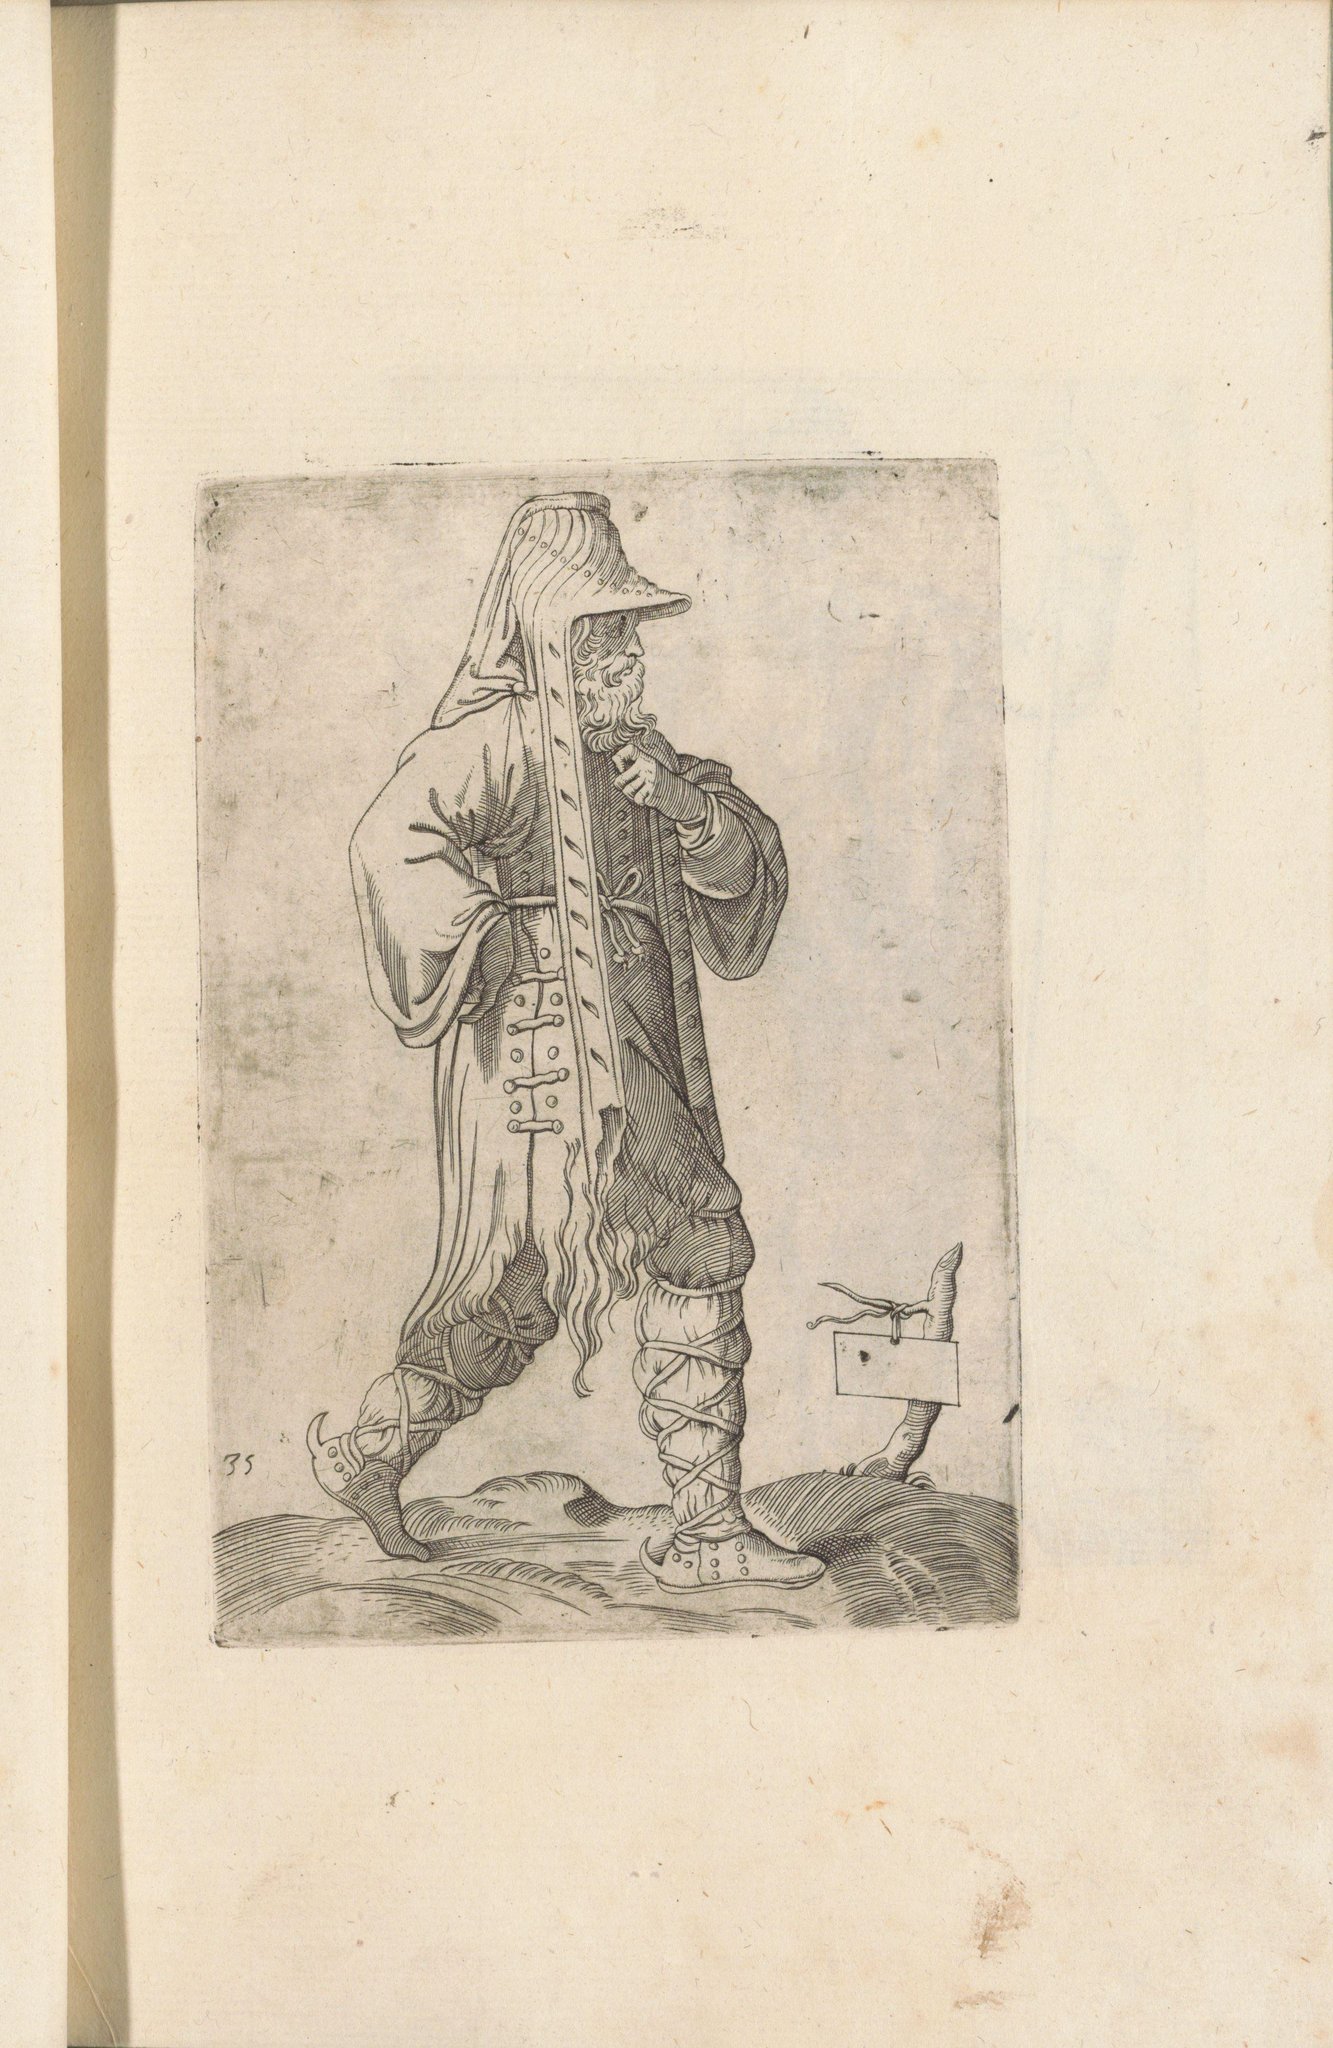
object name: costume print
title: Man met baard (land onbekend)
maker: ferando bertelli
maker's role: print maker, publisher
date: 1569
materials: paper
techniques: engraving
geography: venice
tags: fashion plates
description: Een man met baard, lopend naar rechts, gekleed in muts met lange zijflappen, met beenwindsels. Onderdeel van het kostuumboek getiteld 'Omnium fere gentium nostrae aetatis habitus, nunquam ante hac aediti', Venetië 1569. Heruitgave uit 1569 van de eerste editie uit 1563.